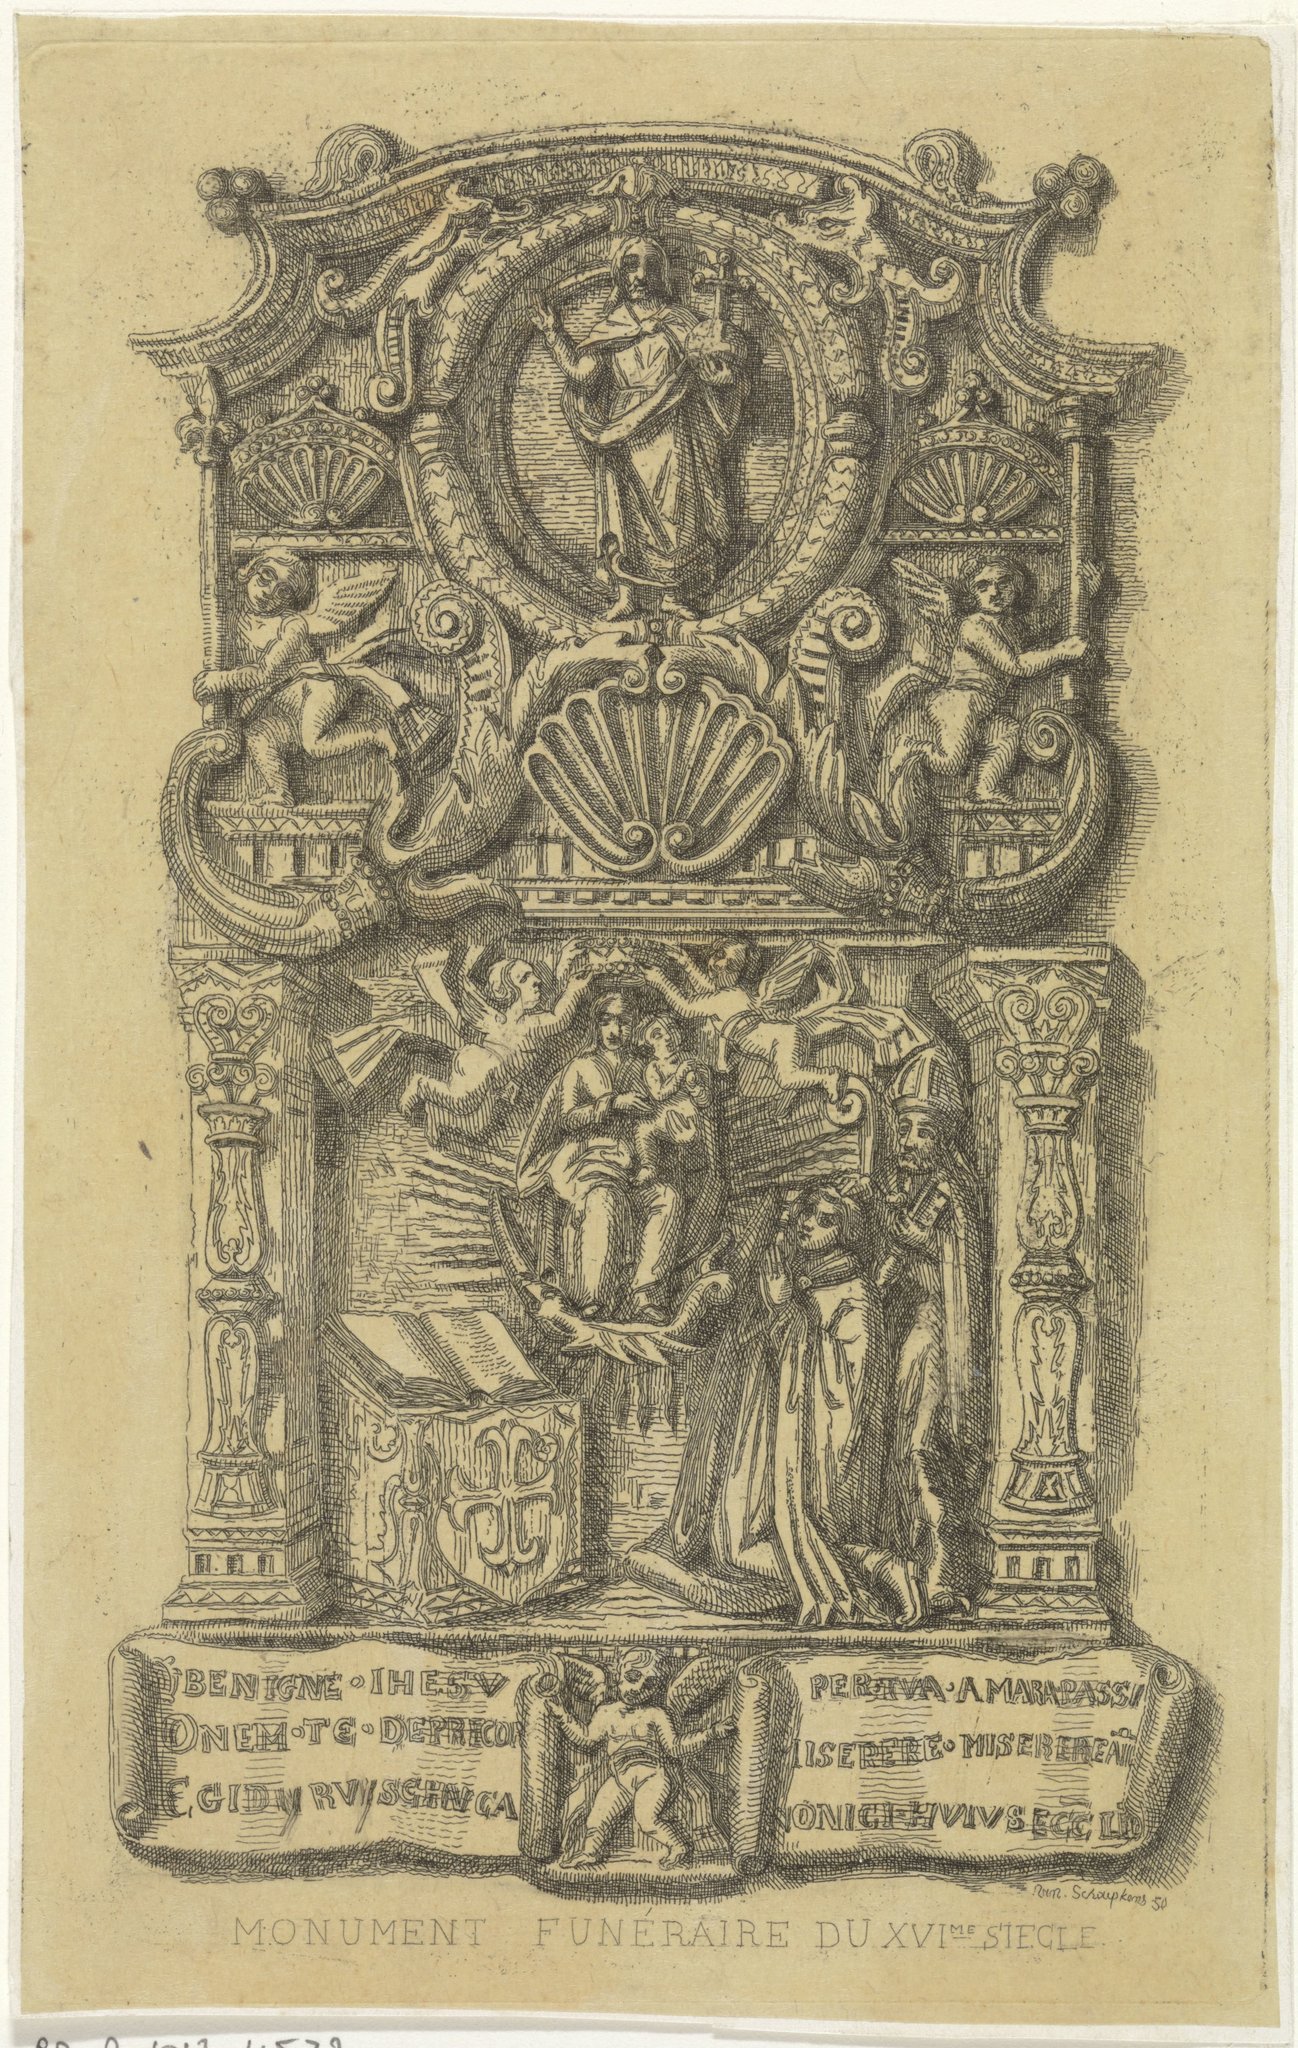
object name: print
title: Monument funéraire du XVIe siècle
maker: arnoud schaepkens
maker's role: print maker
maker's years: 1816-1904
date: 1831-1904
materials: paper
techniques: etching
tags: coronation of mary by one or more angels, grave, tomb and other grave-forms and grave-markers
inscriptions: collector's mark: Lugt 2228